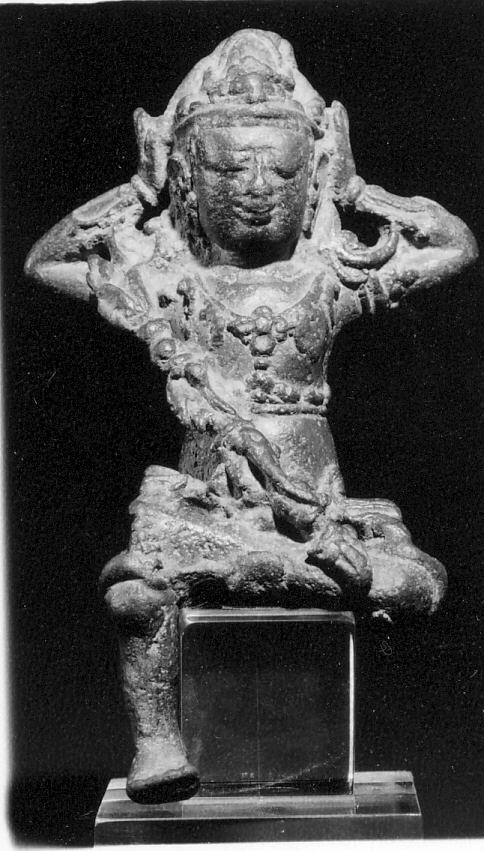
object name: figure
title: Seated Divinity with Large Vajra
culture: indonesian, javanese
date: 901-1100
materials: bronze